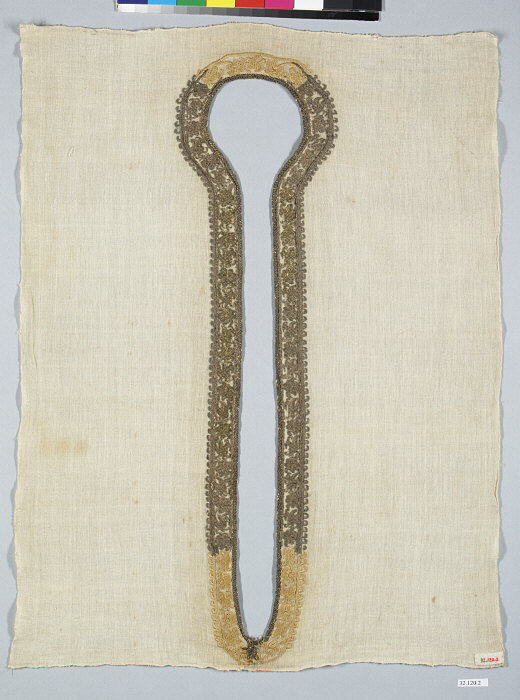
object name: collar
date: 1701-1900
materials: cotton, metal thread